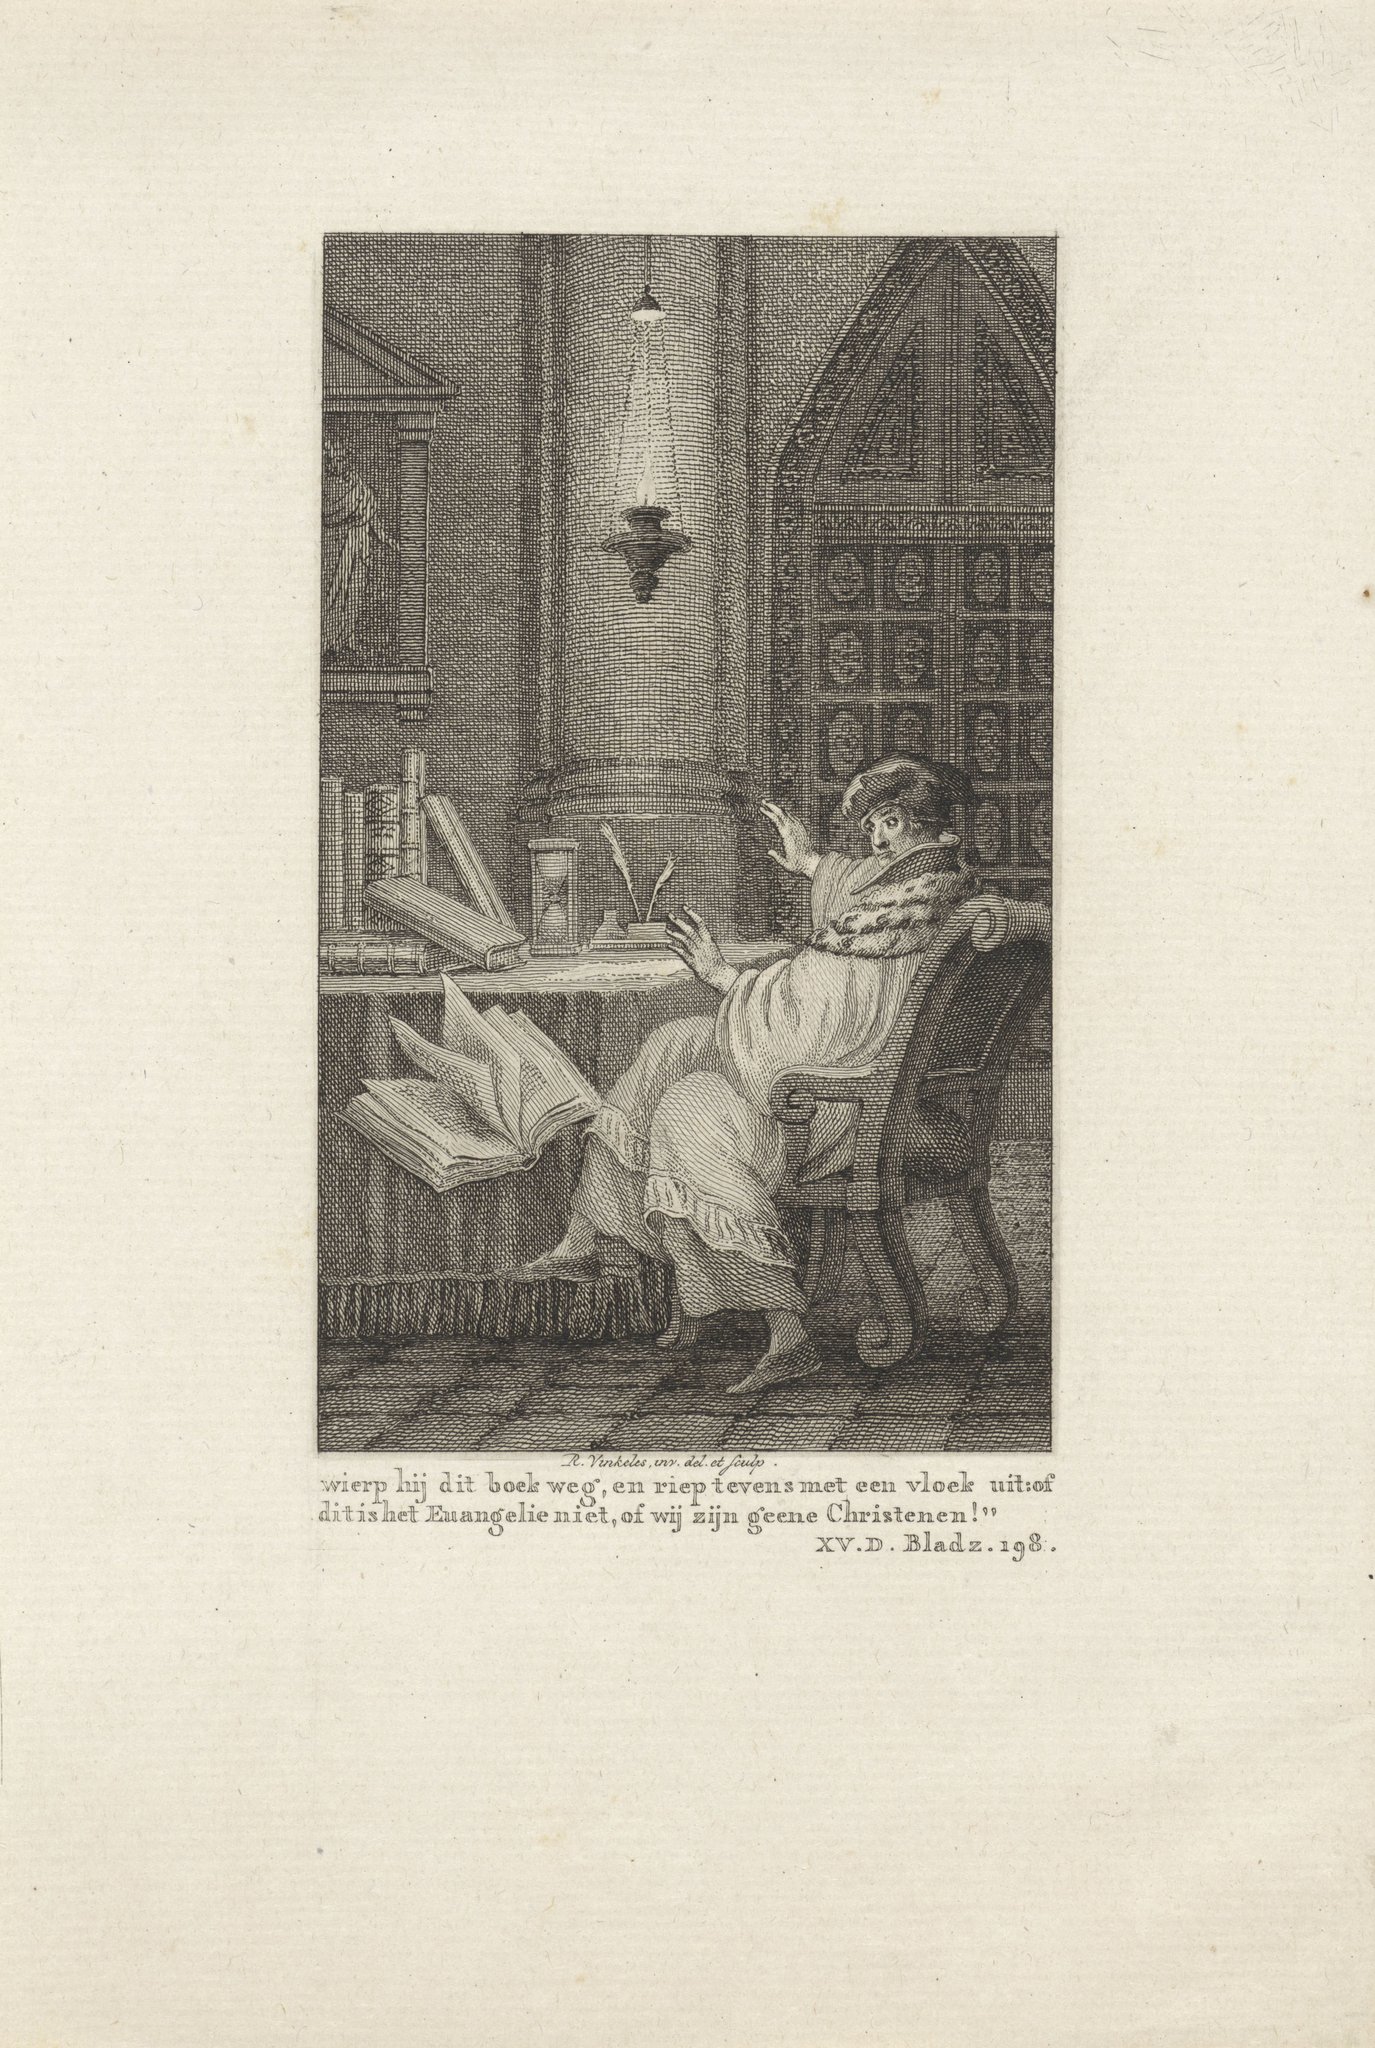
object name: print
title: wierp hij dit boek weg, en riep tevens met een vloek uit: of dit is het Evangelie niet, of wij zijn geene Christenen!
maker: reinier vinkeles (i)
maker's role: draughtsman, print maker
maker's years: 1741-1816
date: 1807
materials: paper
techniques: engraving, etching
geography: amsterdam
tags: writing tools, book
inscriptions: collector's mark: Lugt 2228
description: Deze prent is ook gebruikt als illustratie in: Hamelsveld, Ysbrand van. Algemeene kerkelijke geschiedenis, der Christenen, deel 15. Haarlem: François Bohn, 1807, p. 198.